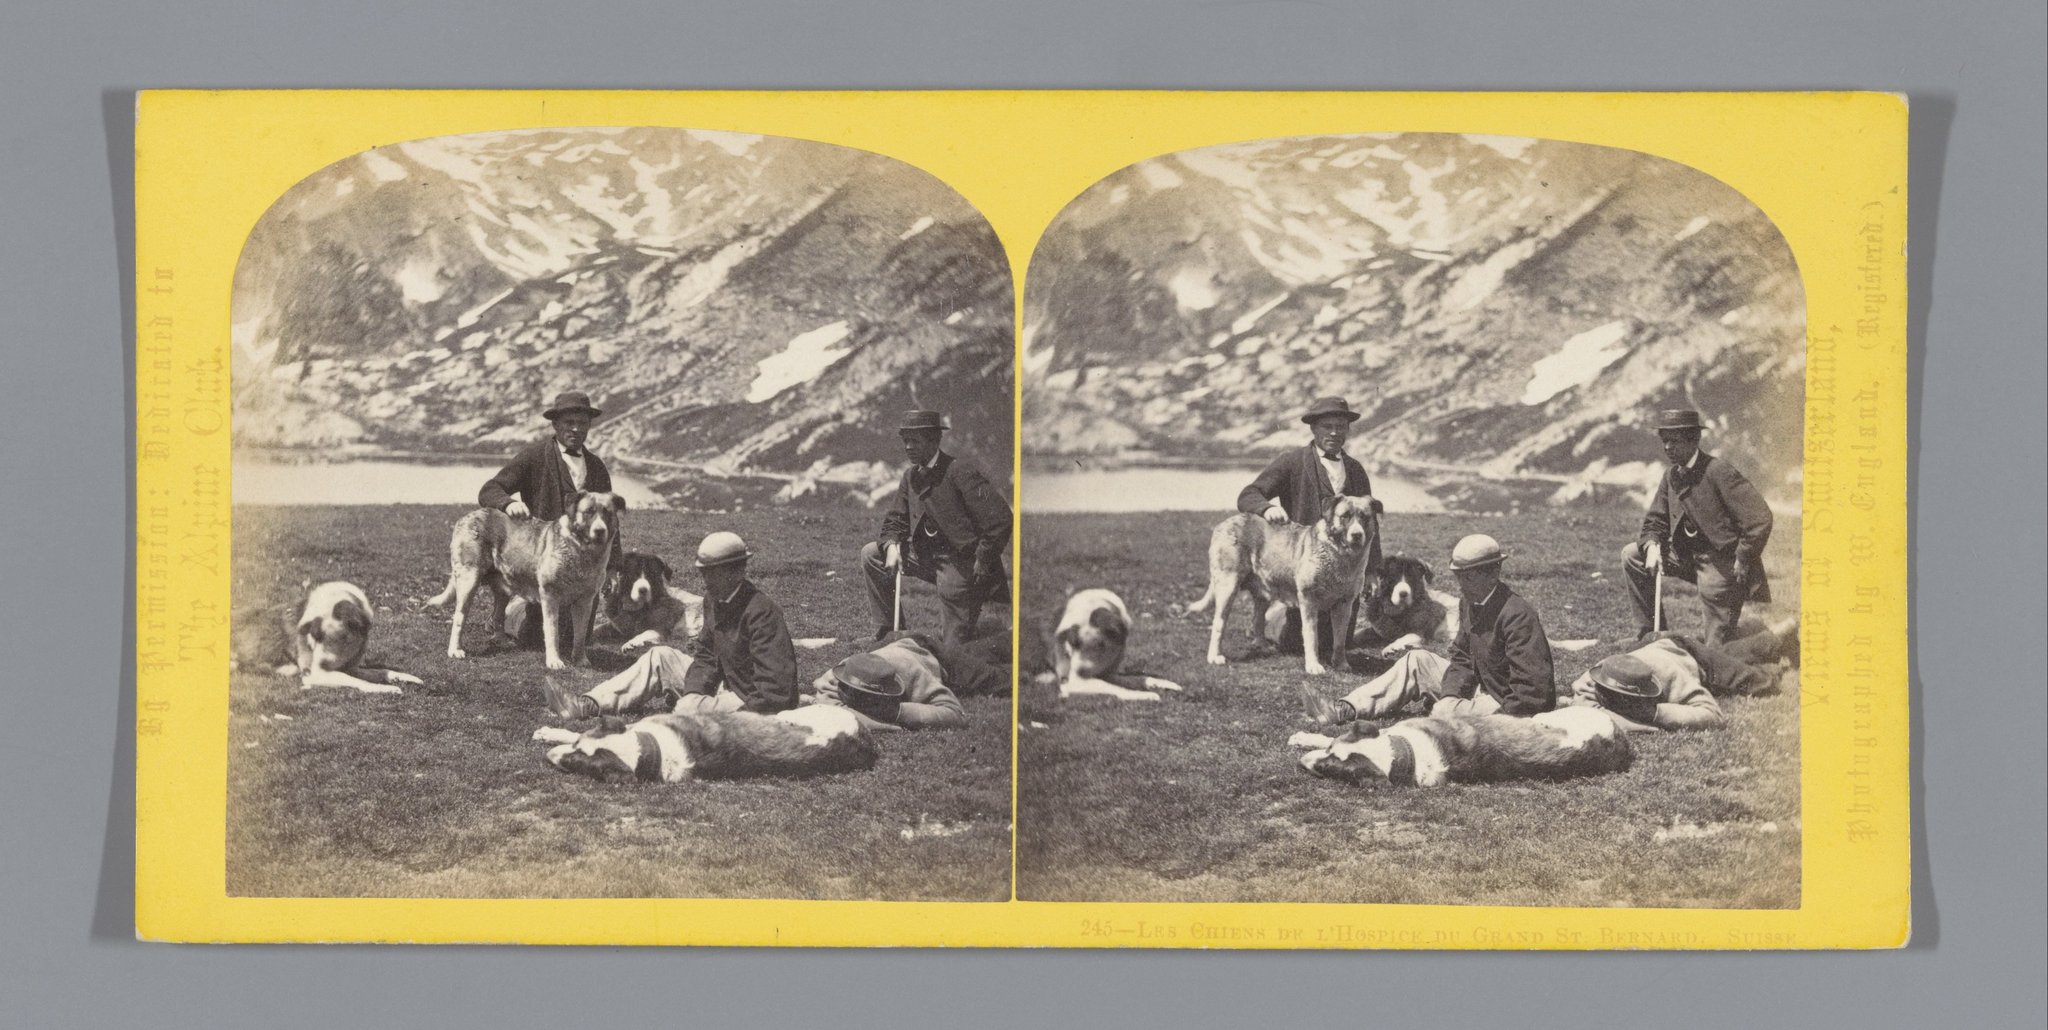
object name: stereograph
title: Les Chiens de l'Hospice du Grand St. Bernard. Suisse.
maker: william england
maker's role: fotograaf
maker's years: 1816-1896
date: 1850-1880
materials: cardboard, photographic support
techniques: albumen print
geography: wallis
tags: adult man, dog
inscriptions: inscription: ‘Views of Switzerland, photographed by W. England. (Registered) Under the Special Patronage of the Alpine Club.’, number: ‘245’